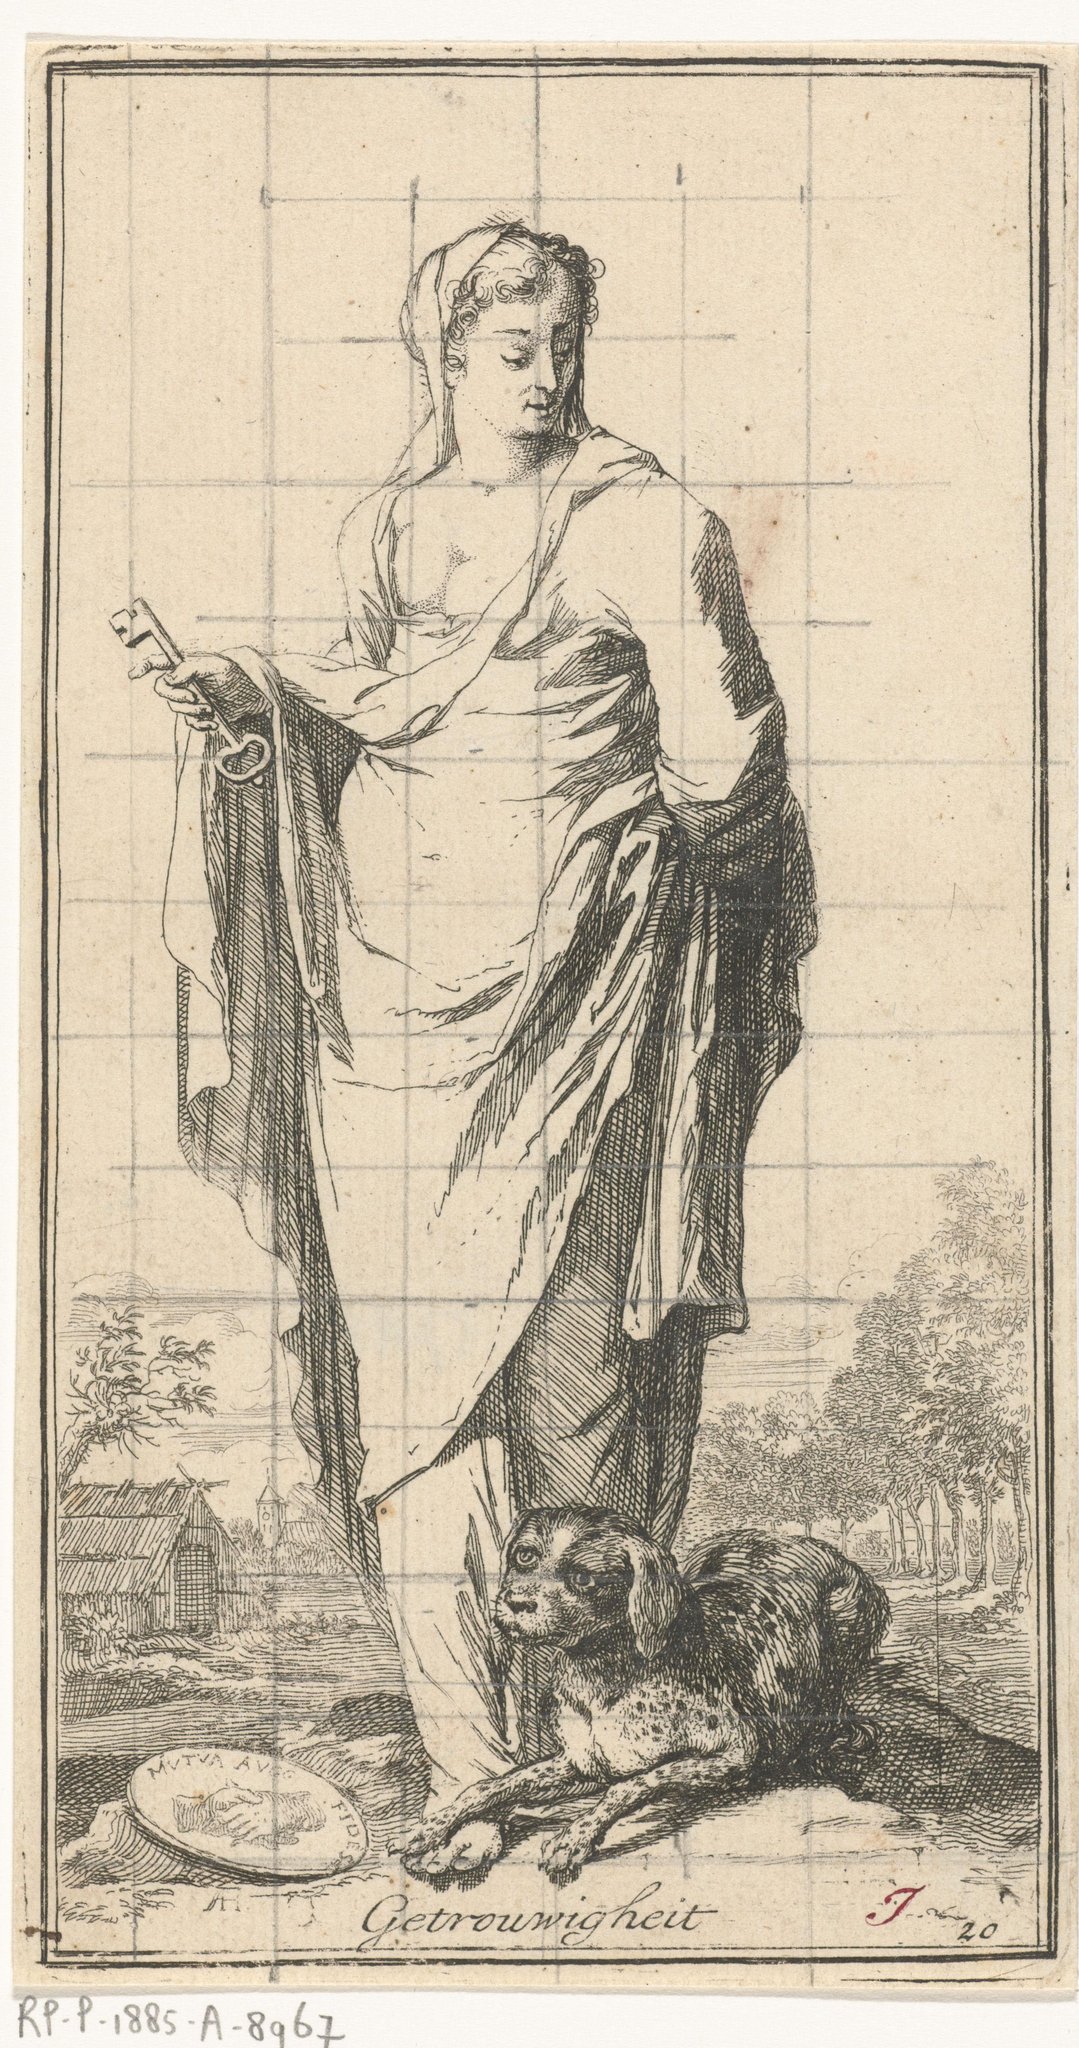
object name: print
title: Personificatie van trouw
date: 1710-1719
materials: paper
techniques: etching, pen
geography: amsterdam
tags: faith, 'fides'; 'fede', 'fede catholica', 'fede christiana', 'fede christiana catholica' (ripa) ~ one of the three theological virtues, key, dog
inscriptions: collector's mark: Lugt 2228, inscription: ‘J’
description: Een vrouwfiguur als personificatie van trouw met in haar rechterhand een sleutel en aan haar voeten een hond. Links op de voorgrond een medaillon met twee in elkaar geslagen handen en een spreuk in het Latijn. Prent uit een serie van 41 zinnebeelden.